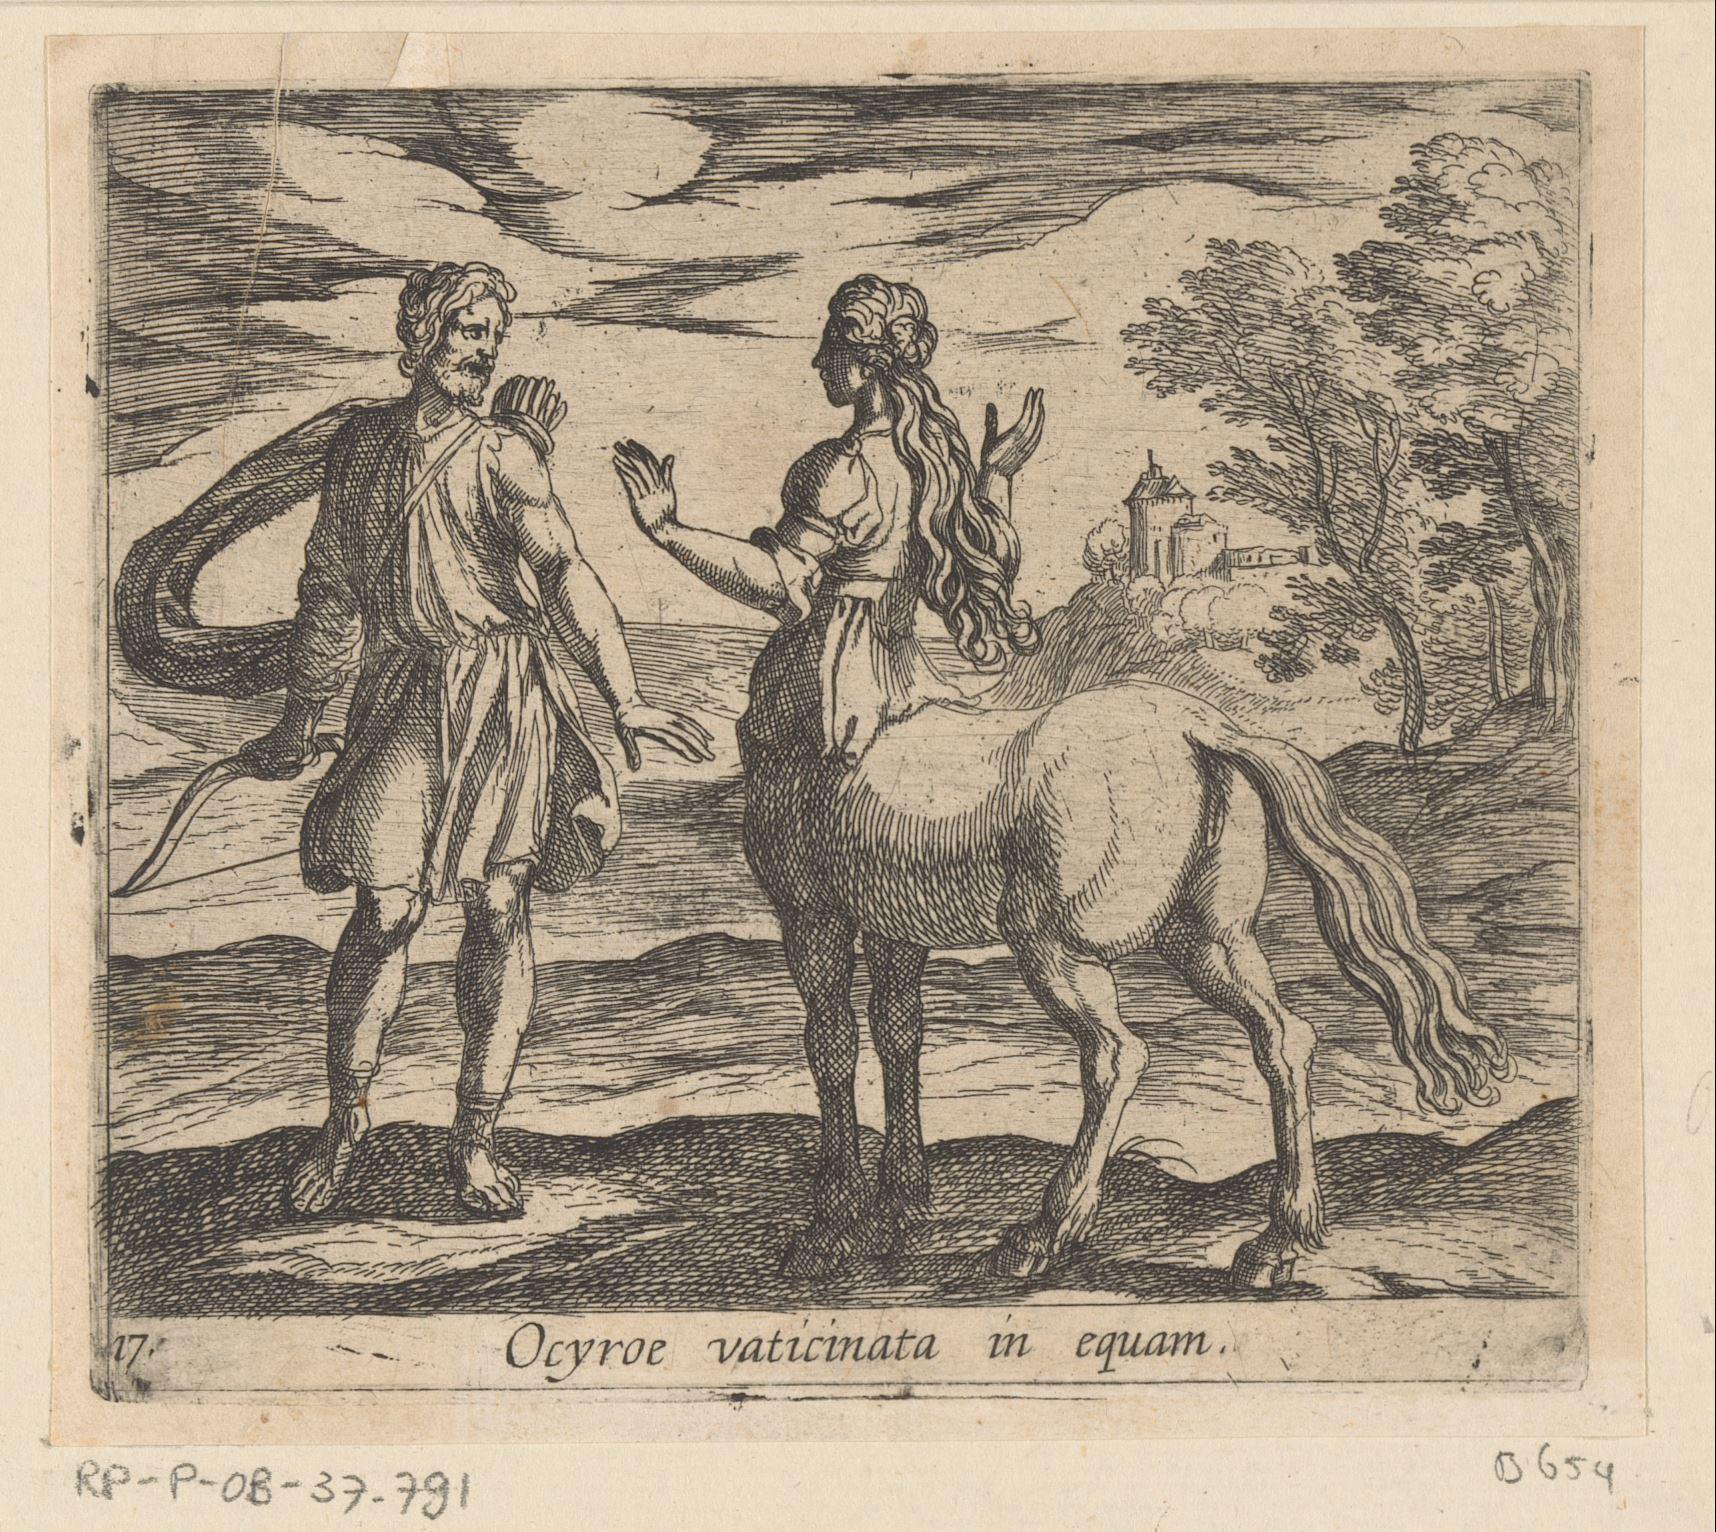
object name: print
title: Metamorfosen van Ovidius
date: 1606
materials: paper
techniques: etching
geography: antwerp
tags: ocyroe changed into a mare: when she is foretelling the fates of her father chiron and the young aesculapius, ocyroe is changed into a mare (ovid, metamorphoses ii 657)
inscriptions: collector's mark: Lugt 240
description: Ocyrhoe, de dochter van Chiron, wordt in een paard veranderd, na voorspeld te hebben hoe de toekomst van Asclepius en haar vader zal zijn. Titel in het Latijn in ondermarge.